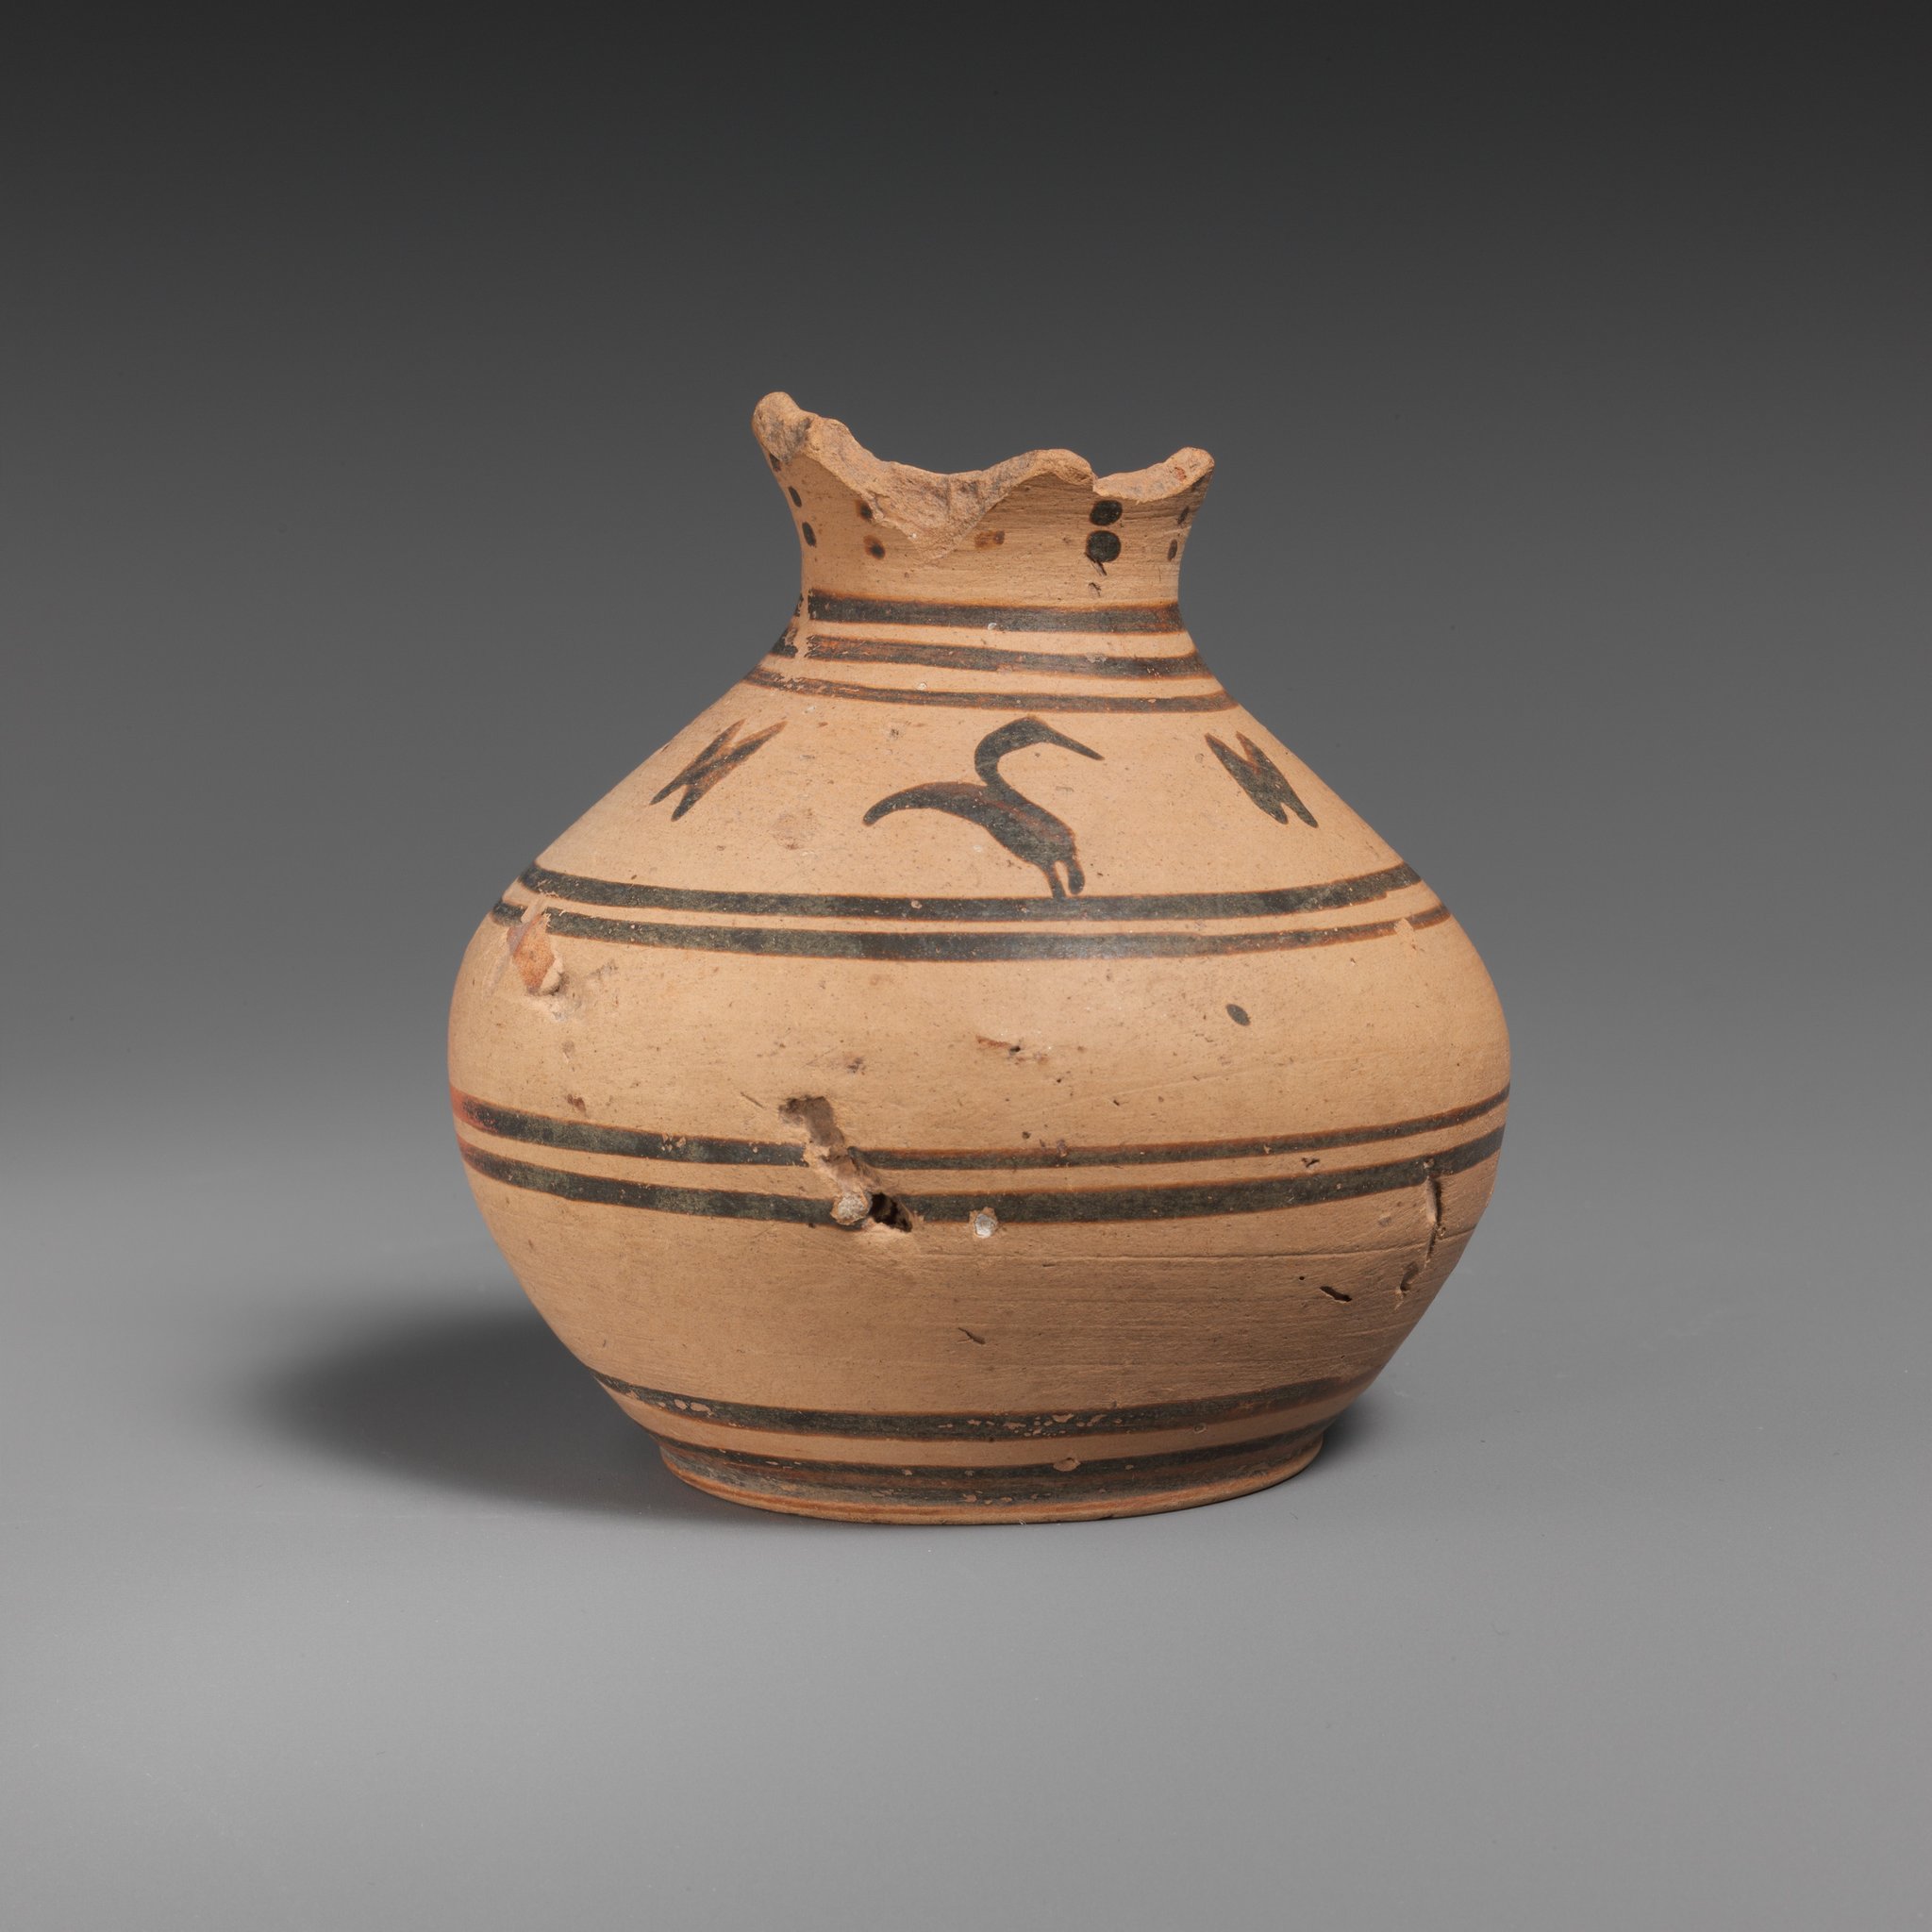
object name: oinochoe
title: Terracotta oinochoe (jug)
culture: greek, attic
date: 734-668 BCE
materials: terracotta